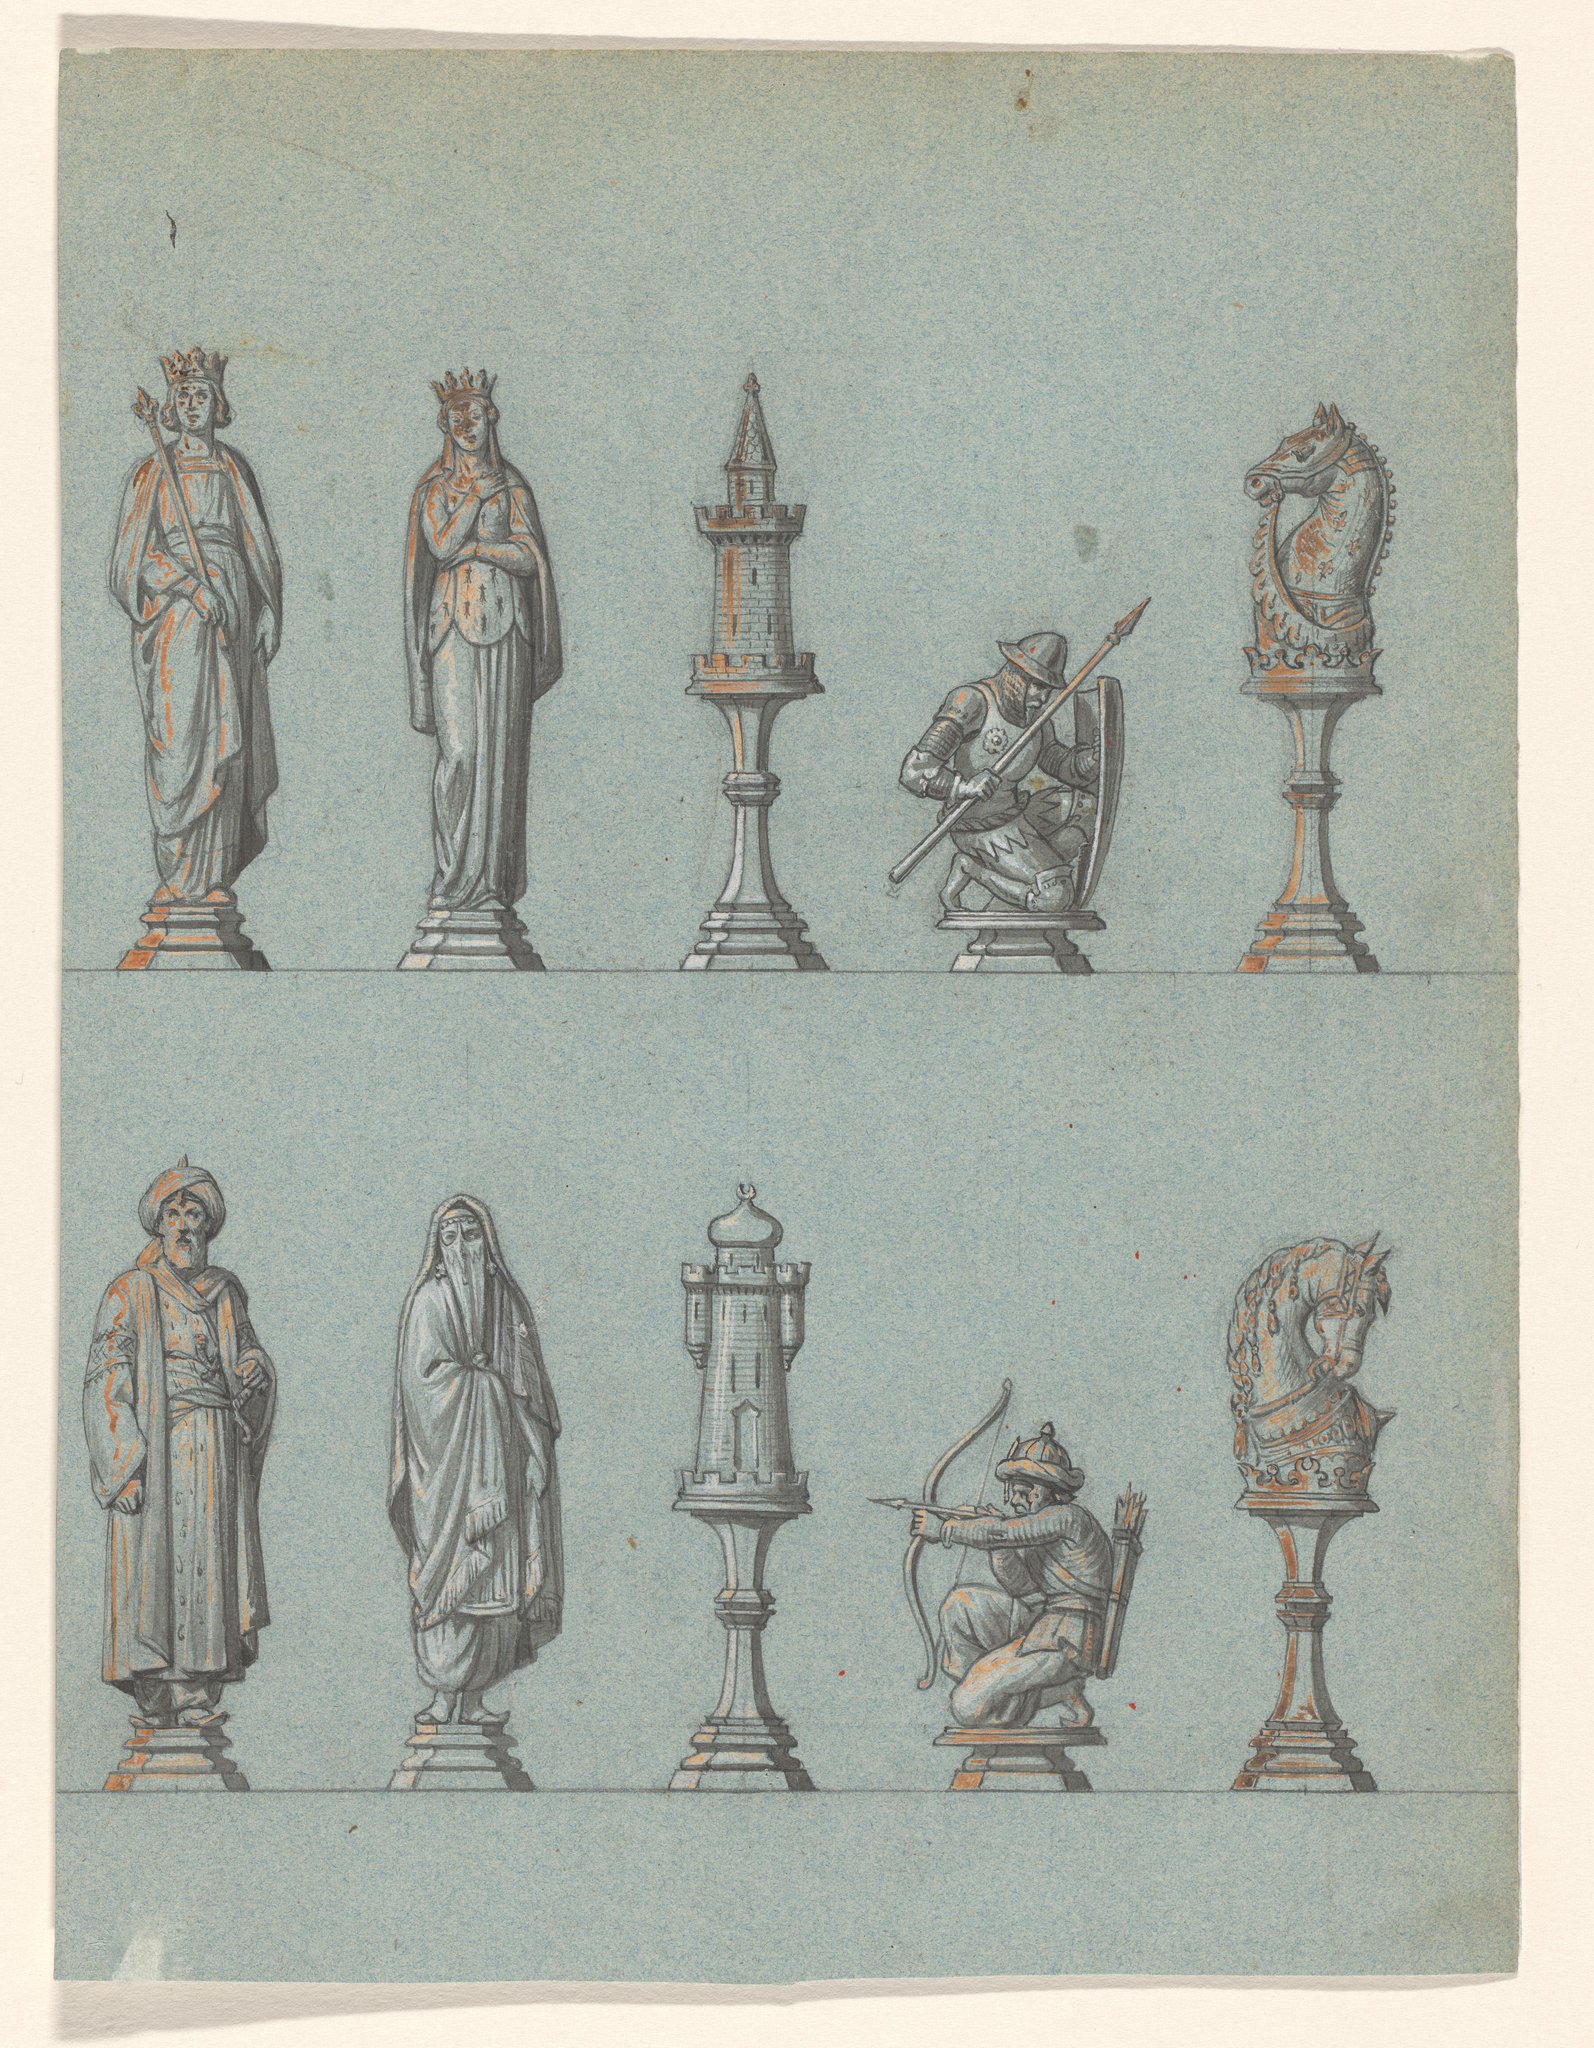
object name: design drawing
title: Ontwerp voor schaakstukken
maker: Anonymous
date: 1850-1875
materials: chalk, paint, ink, paper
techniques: brush, pen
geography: france